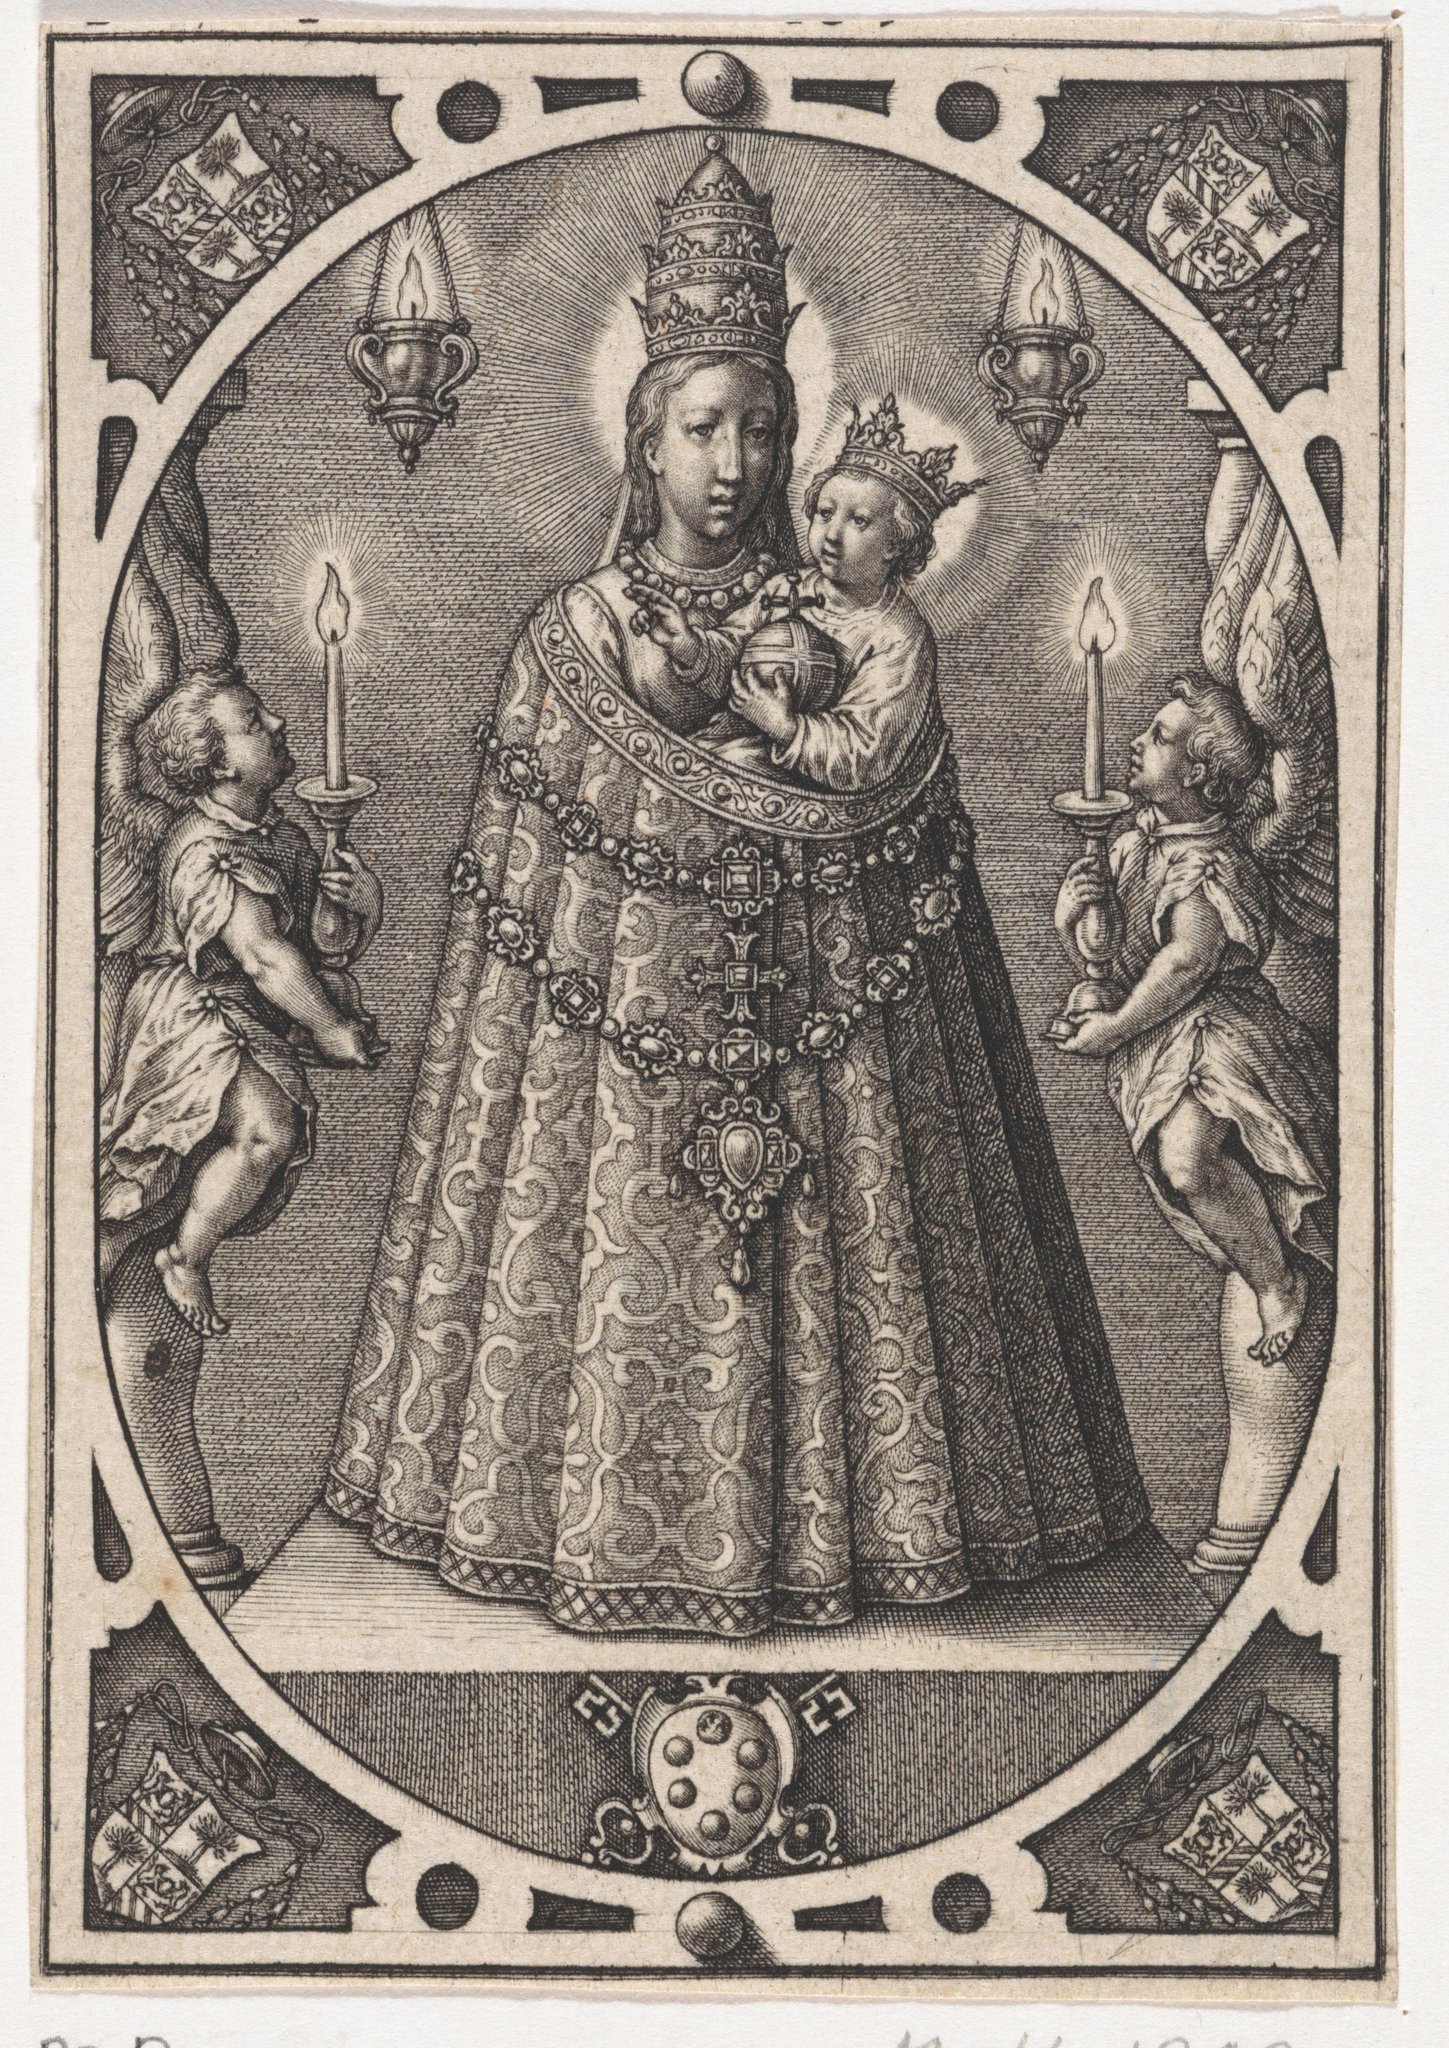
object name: print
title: Onze Lieve Vrouw van Loreto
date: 1603-1607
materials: paper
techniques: engraving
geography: antwerp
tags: leo xi, madonna: mary standing (or half-length), christ-child close to her bosom (+ angel(s)), legends and miracles ~ mary, insignia of the pope, e.g. tiara, armorial bearing, heraldry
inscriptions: collector's mark: Lugt 2228, collector's mark: Lugt 2794, collector's mark: Lugt 567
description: Maria met het Christuskind in de armen in haar mantel. Ze draagt een tiara. Het Kind is gekroond en houdt een rijksappel in de hand. Twee engelen beschijnen hen met het licht van hun kaarsen. Op de verhoging het wapenschild van paus Leo XI.